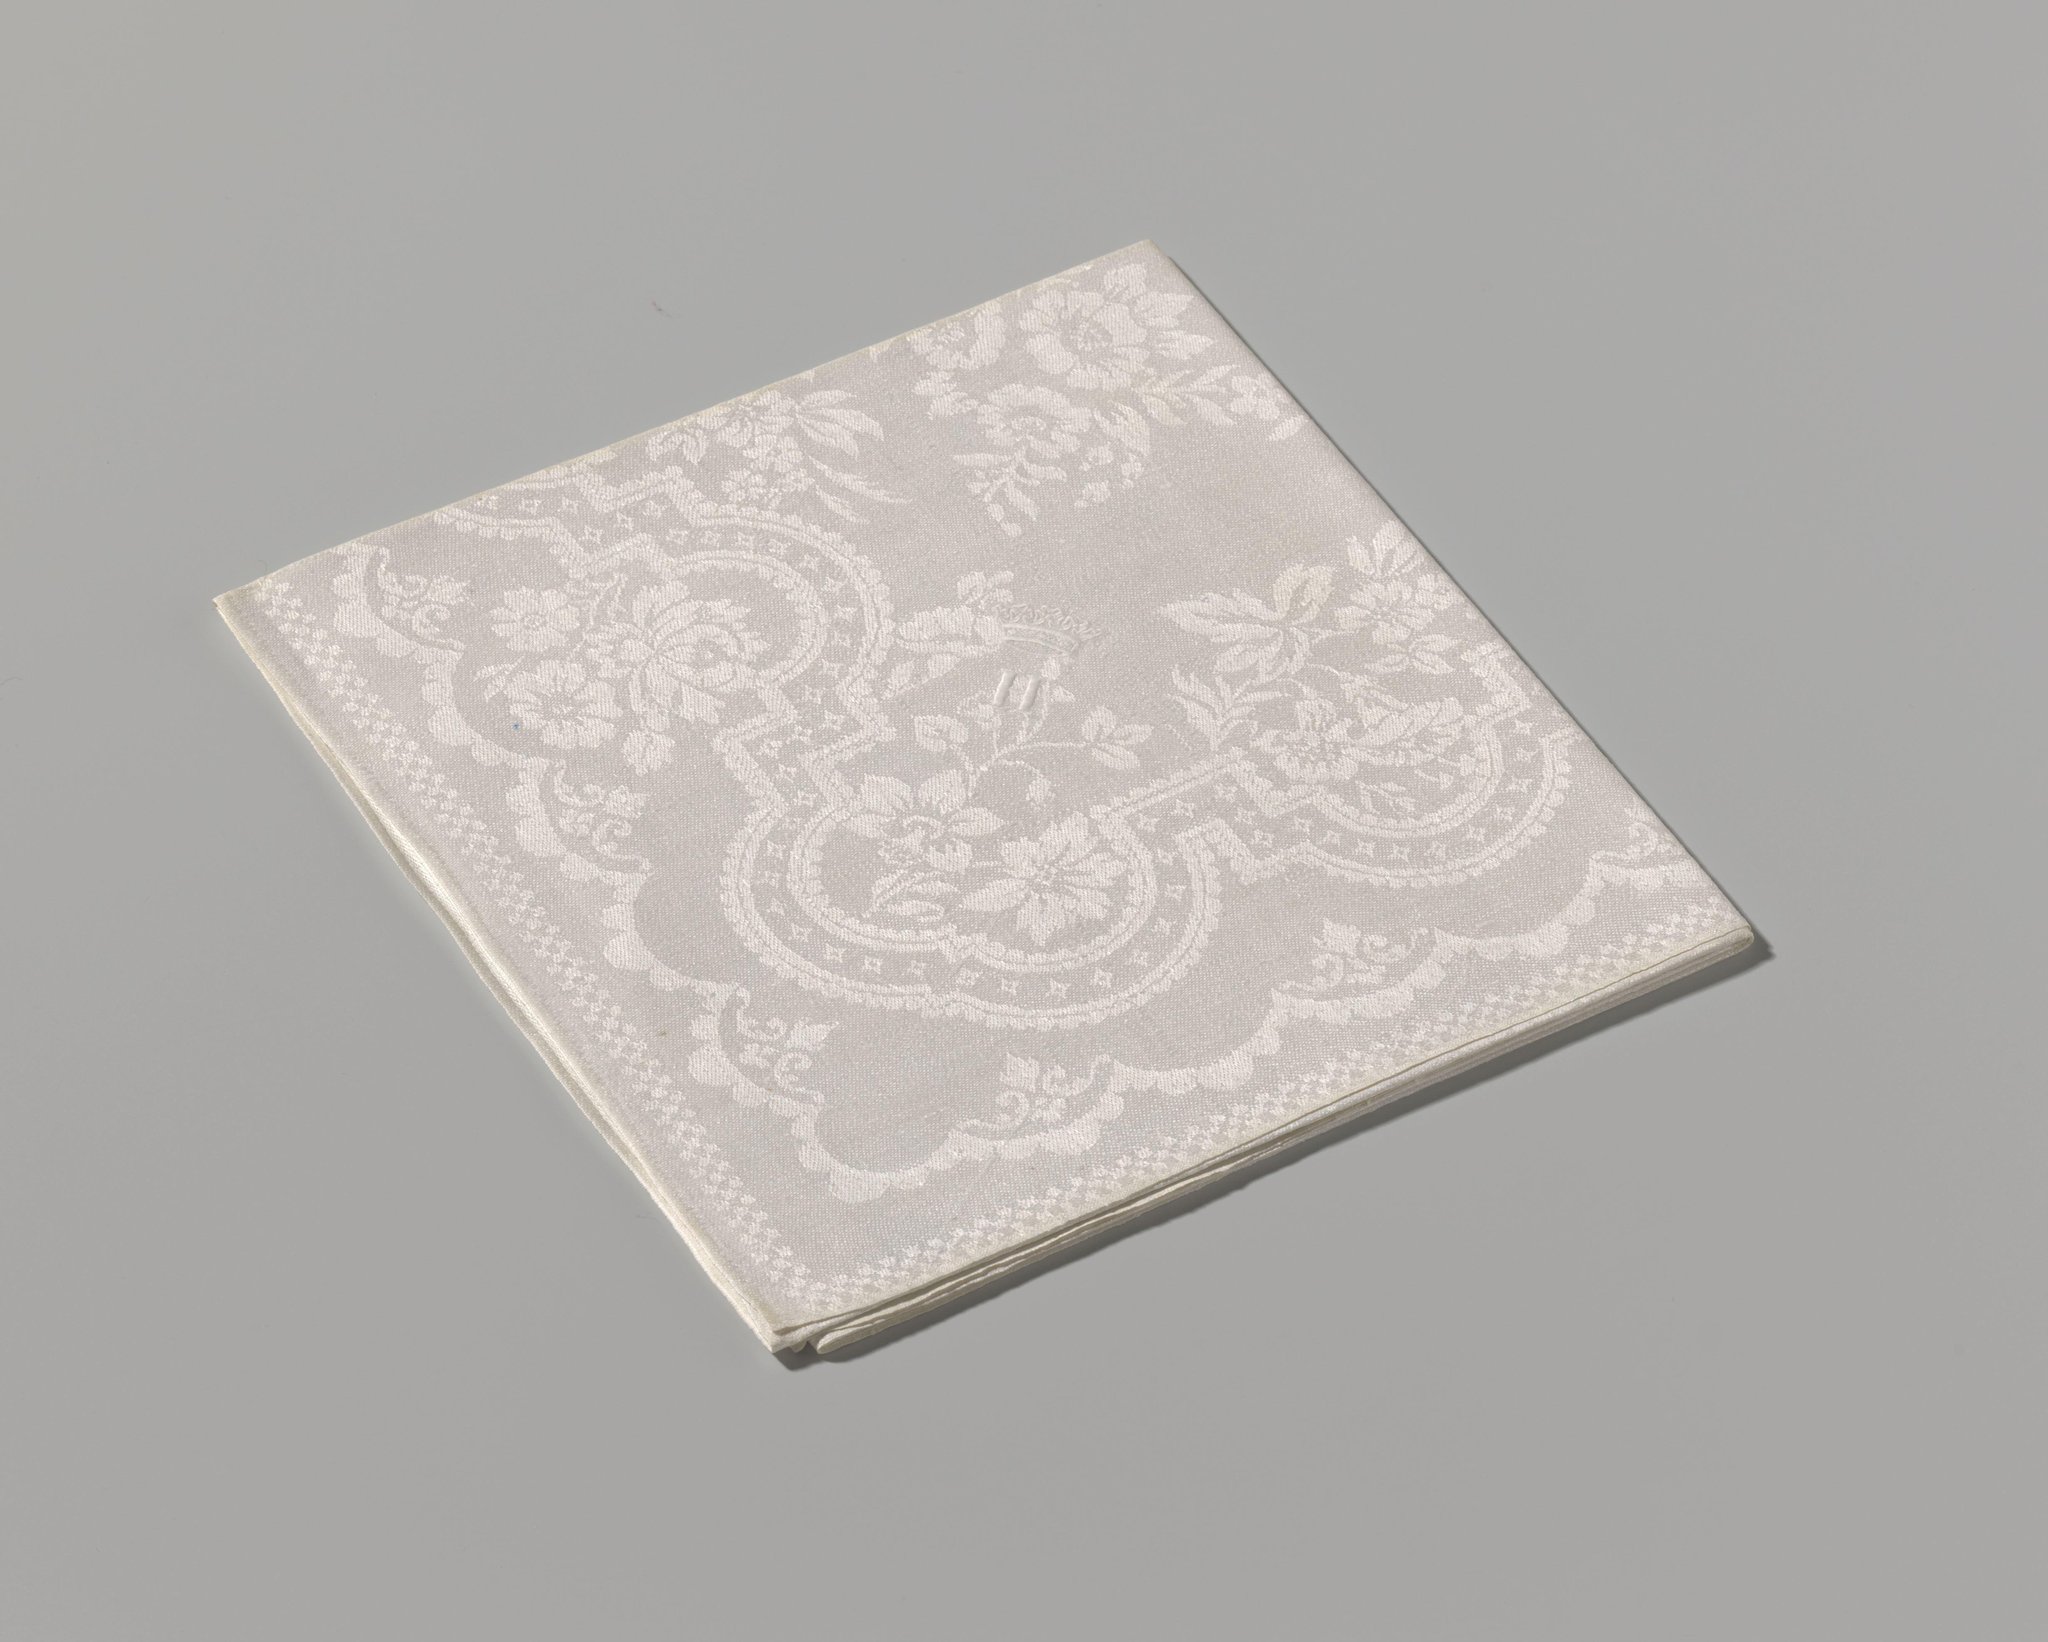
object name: napkin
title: Servet van wit linnendamast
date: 1859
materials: linen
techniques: damask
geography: borne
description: Wit linnen damasten servet met "gebloemde ruit", merk kroon H en 24.